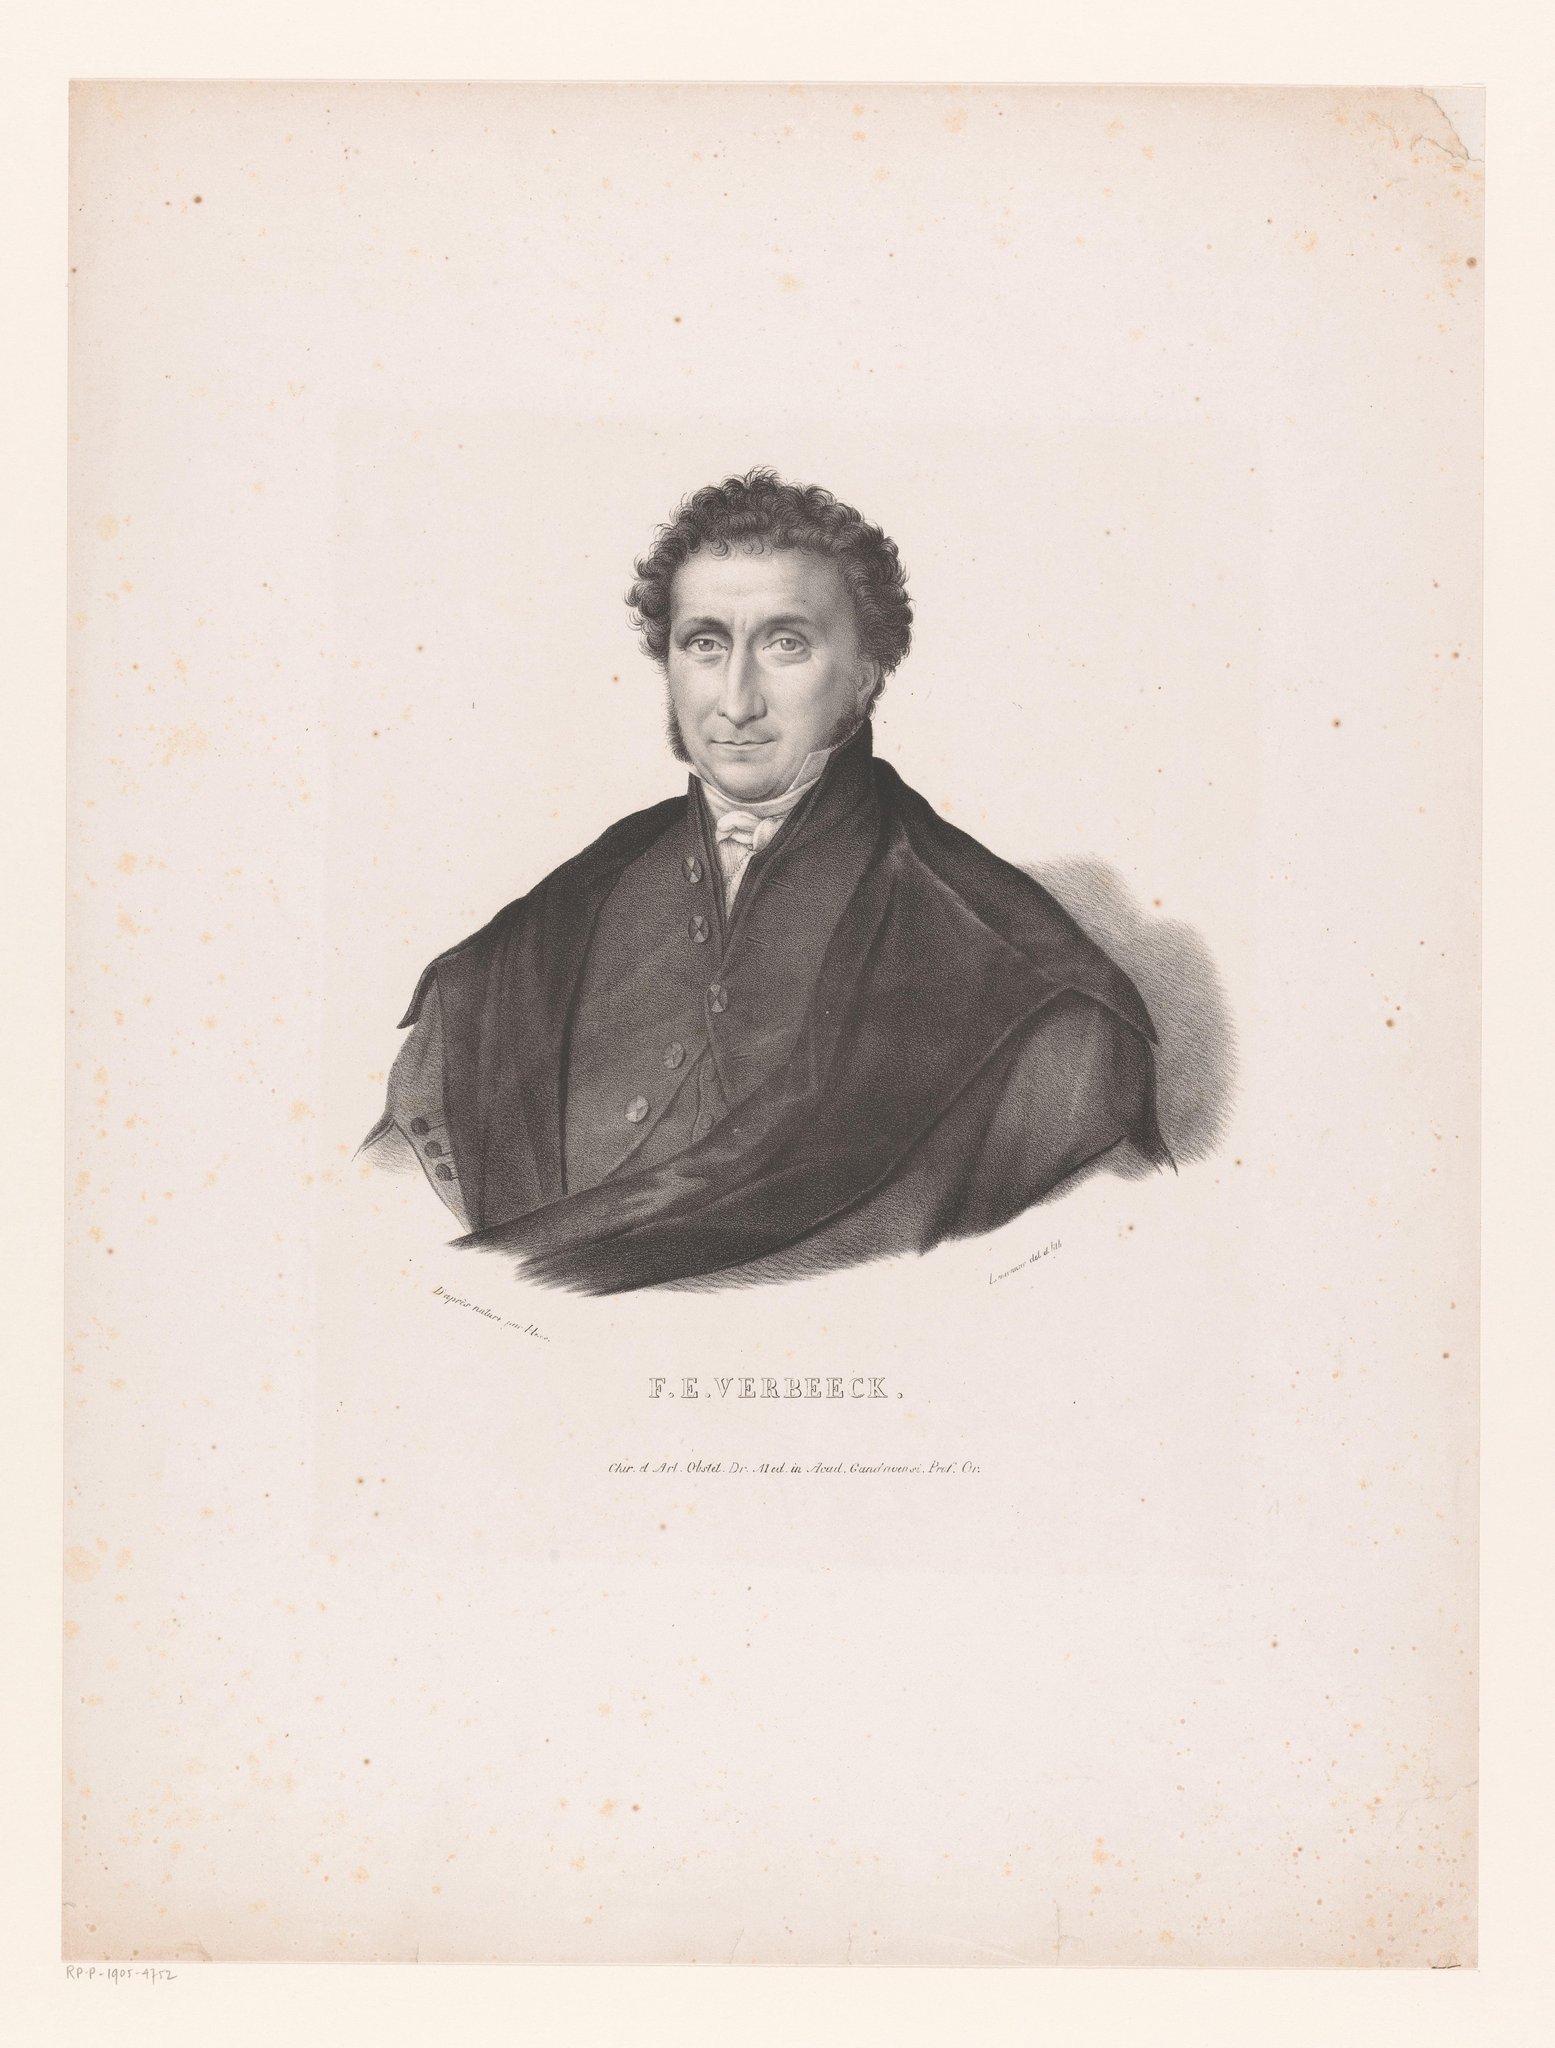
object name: print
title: F.E. Verbeeck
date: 1827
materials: paper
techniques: lithograph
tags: mechelen, ghent, historical persons, professor (+ portrait of teacher, professor)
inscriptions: collector's mark: Lugt 2228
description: Prent verschenen in: Hess, Marcel. Iconographie des professeurs des universites des Pays-Bas. Brussel: Van Someren, 1827.